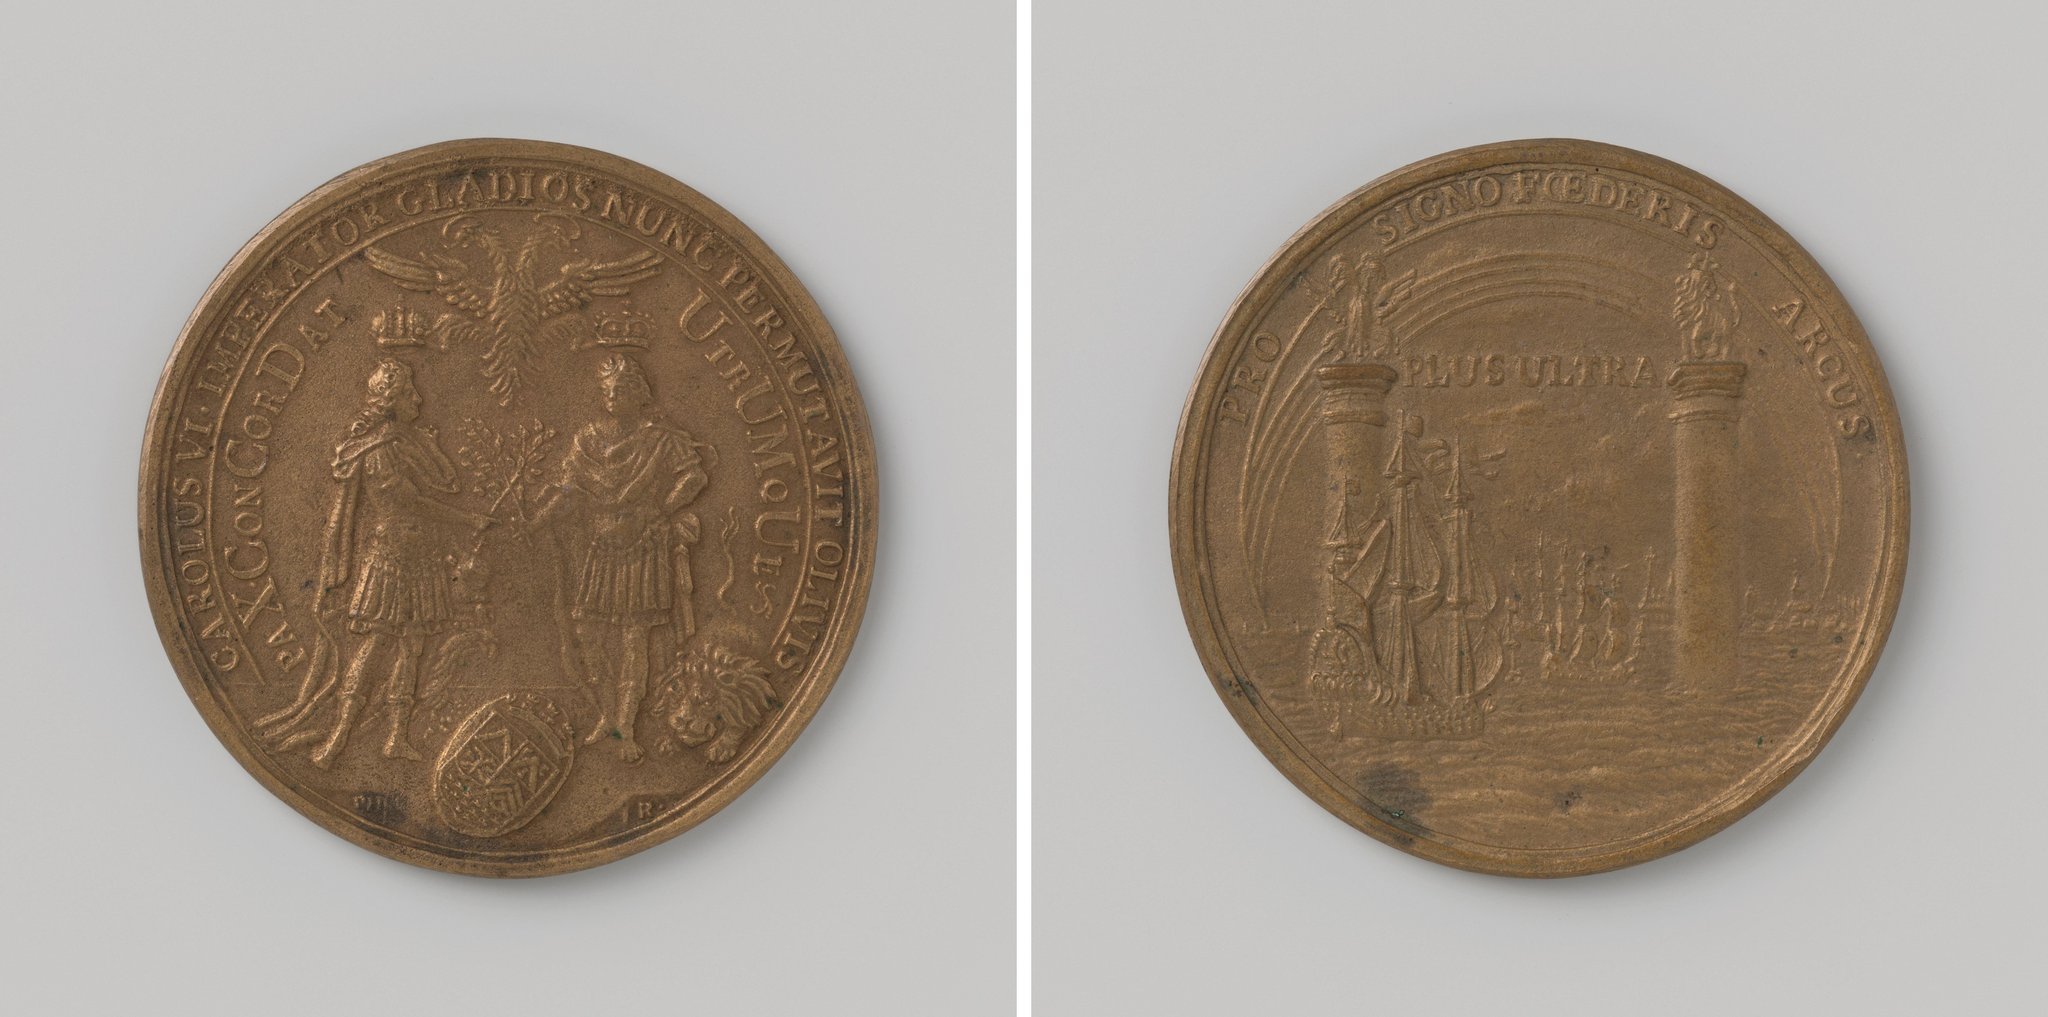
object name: history medal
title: Geheime verdrag van Wenen tussen Spanje en Oostenrijk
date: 1725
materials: bronze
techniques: striking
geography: antwerp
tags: filips v (koning van spanje), vienna, charles vi (holy roman emperor)